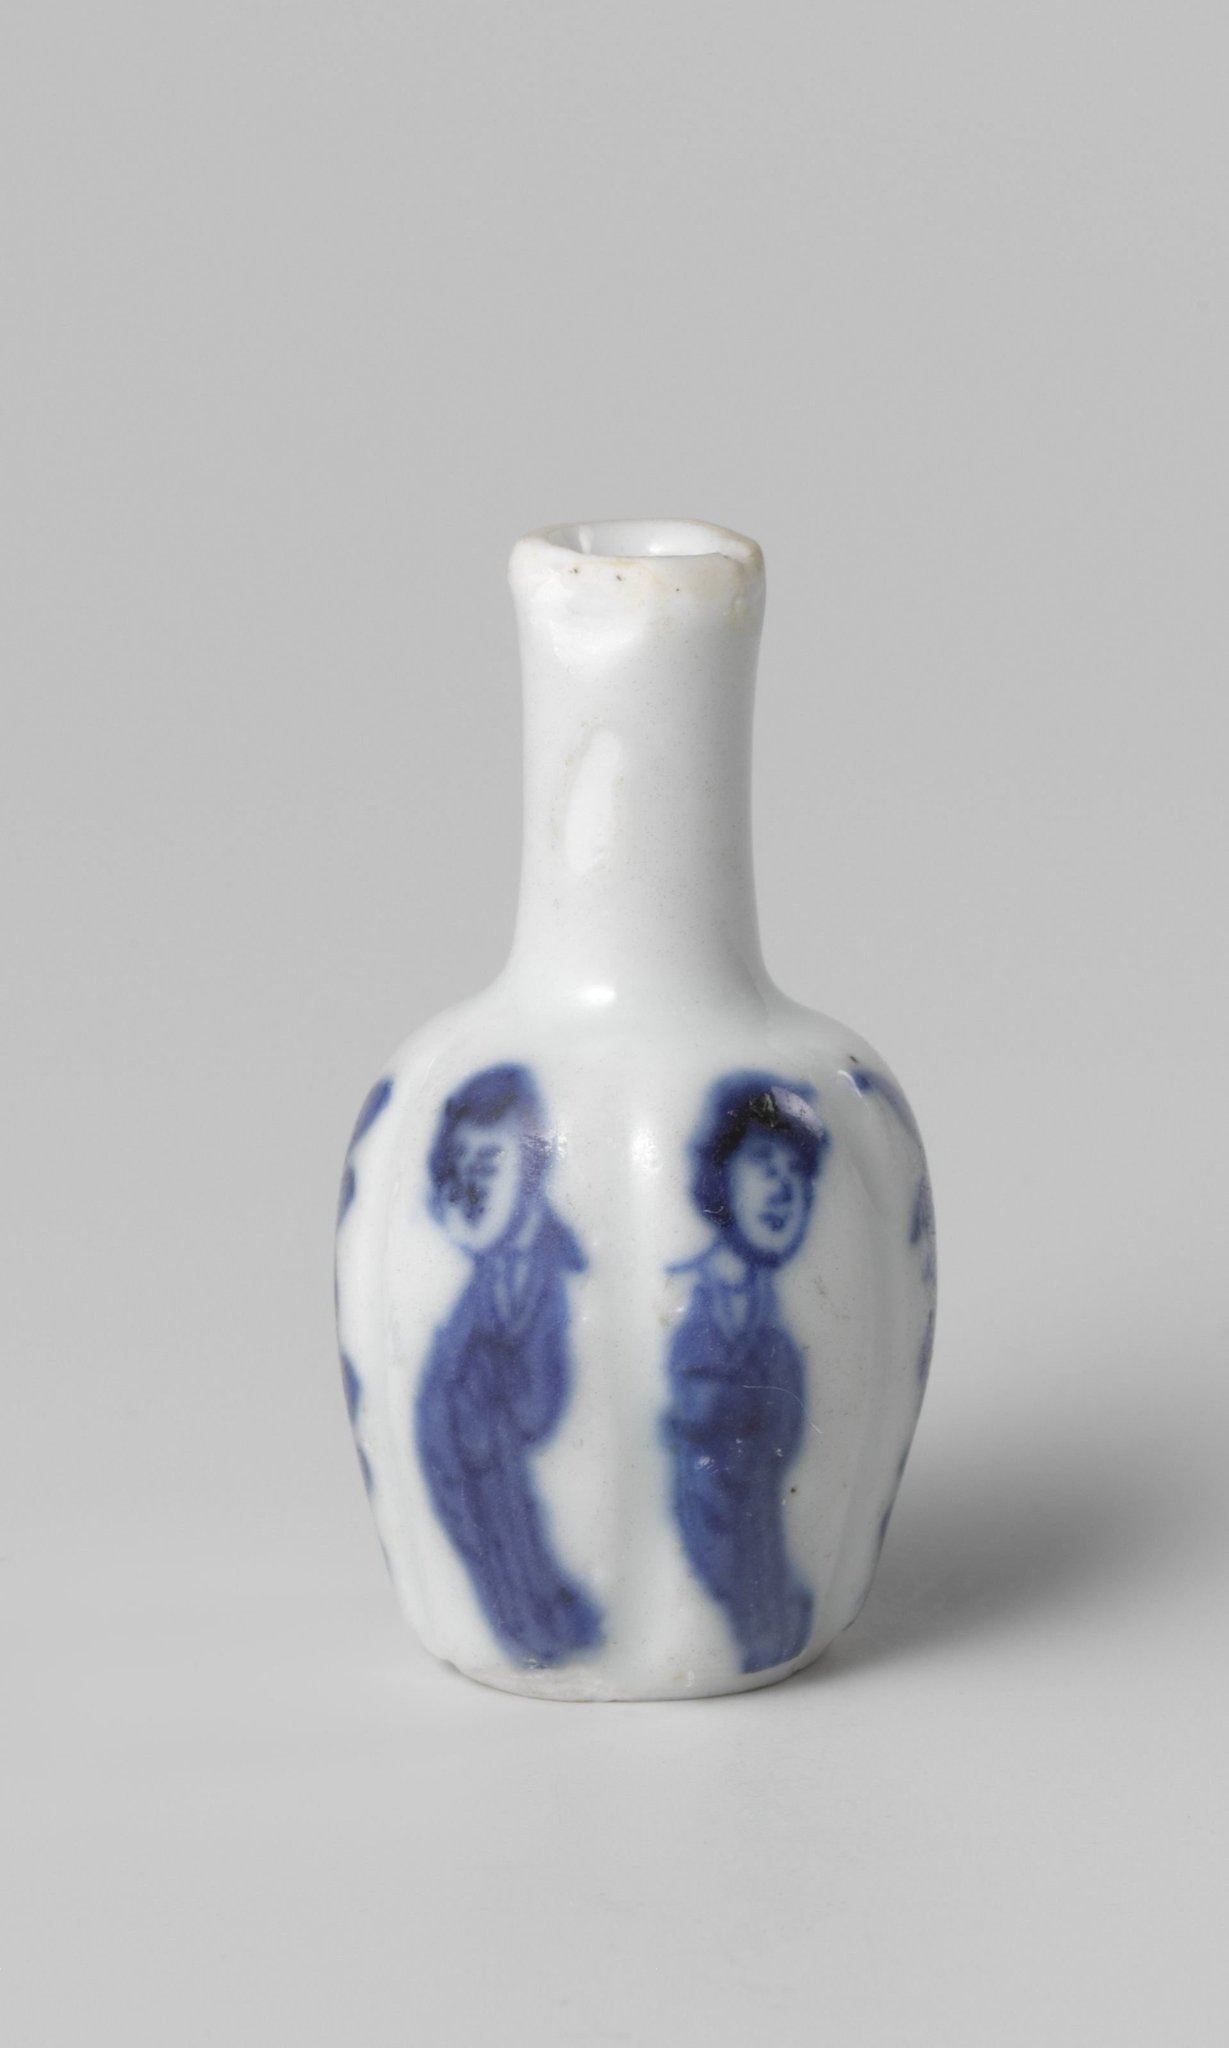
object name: vase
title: Miniature bottle vase with flowering plants and women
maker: Anonymous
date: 1675-1724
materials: cobalt, glaze, paint, porcelain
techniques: firing, turning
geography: china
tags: chinese, ornament derived from plant forms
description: Miniatuur zeslobbige, flesvormige vaas van porselein, beschilderd in onderglazuur blauw. Op de wand zesmaal bloeiende planten en vrouw (lange lijzen). Blauw-wit.